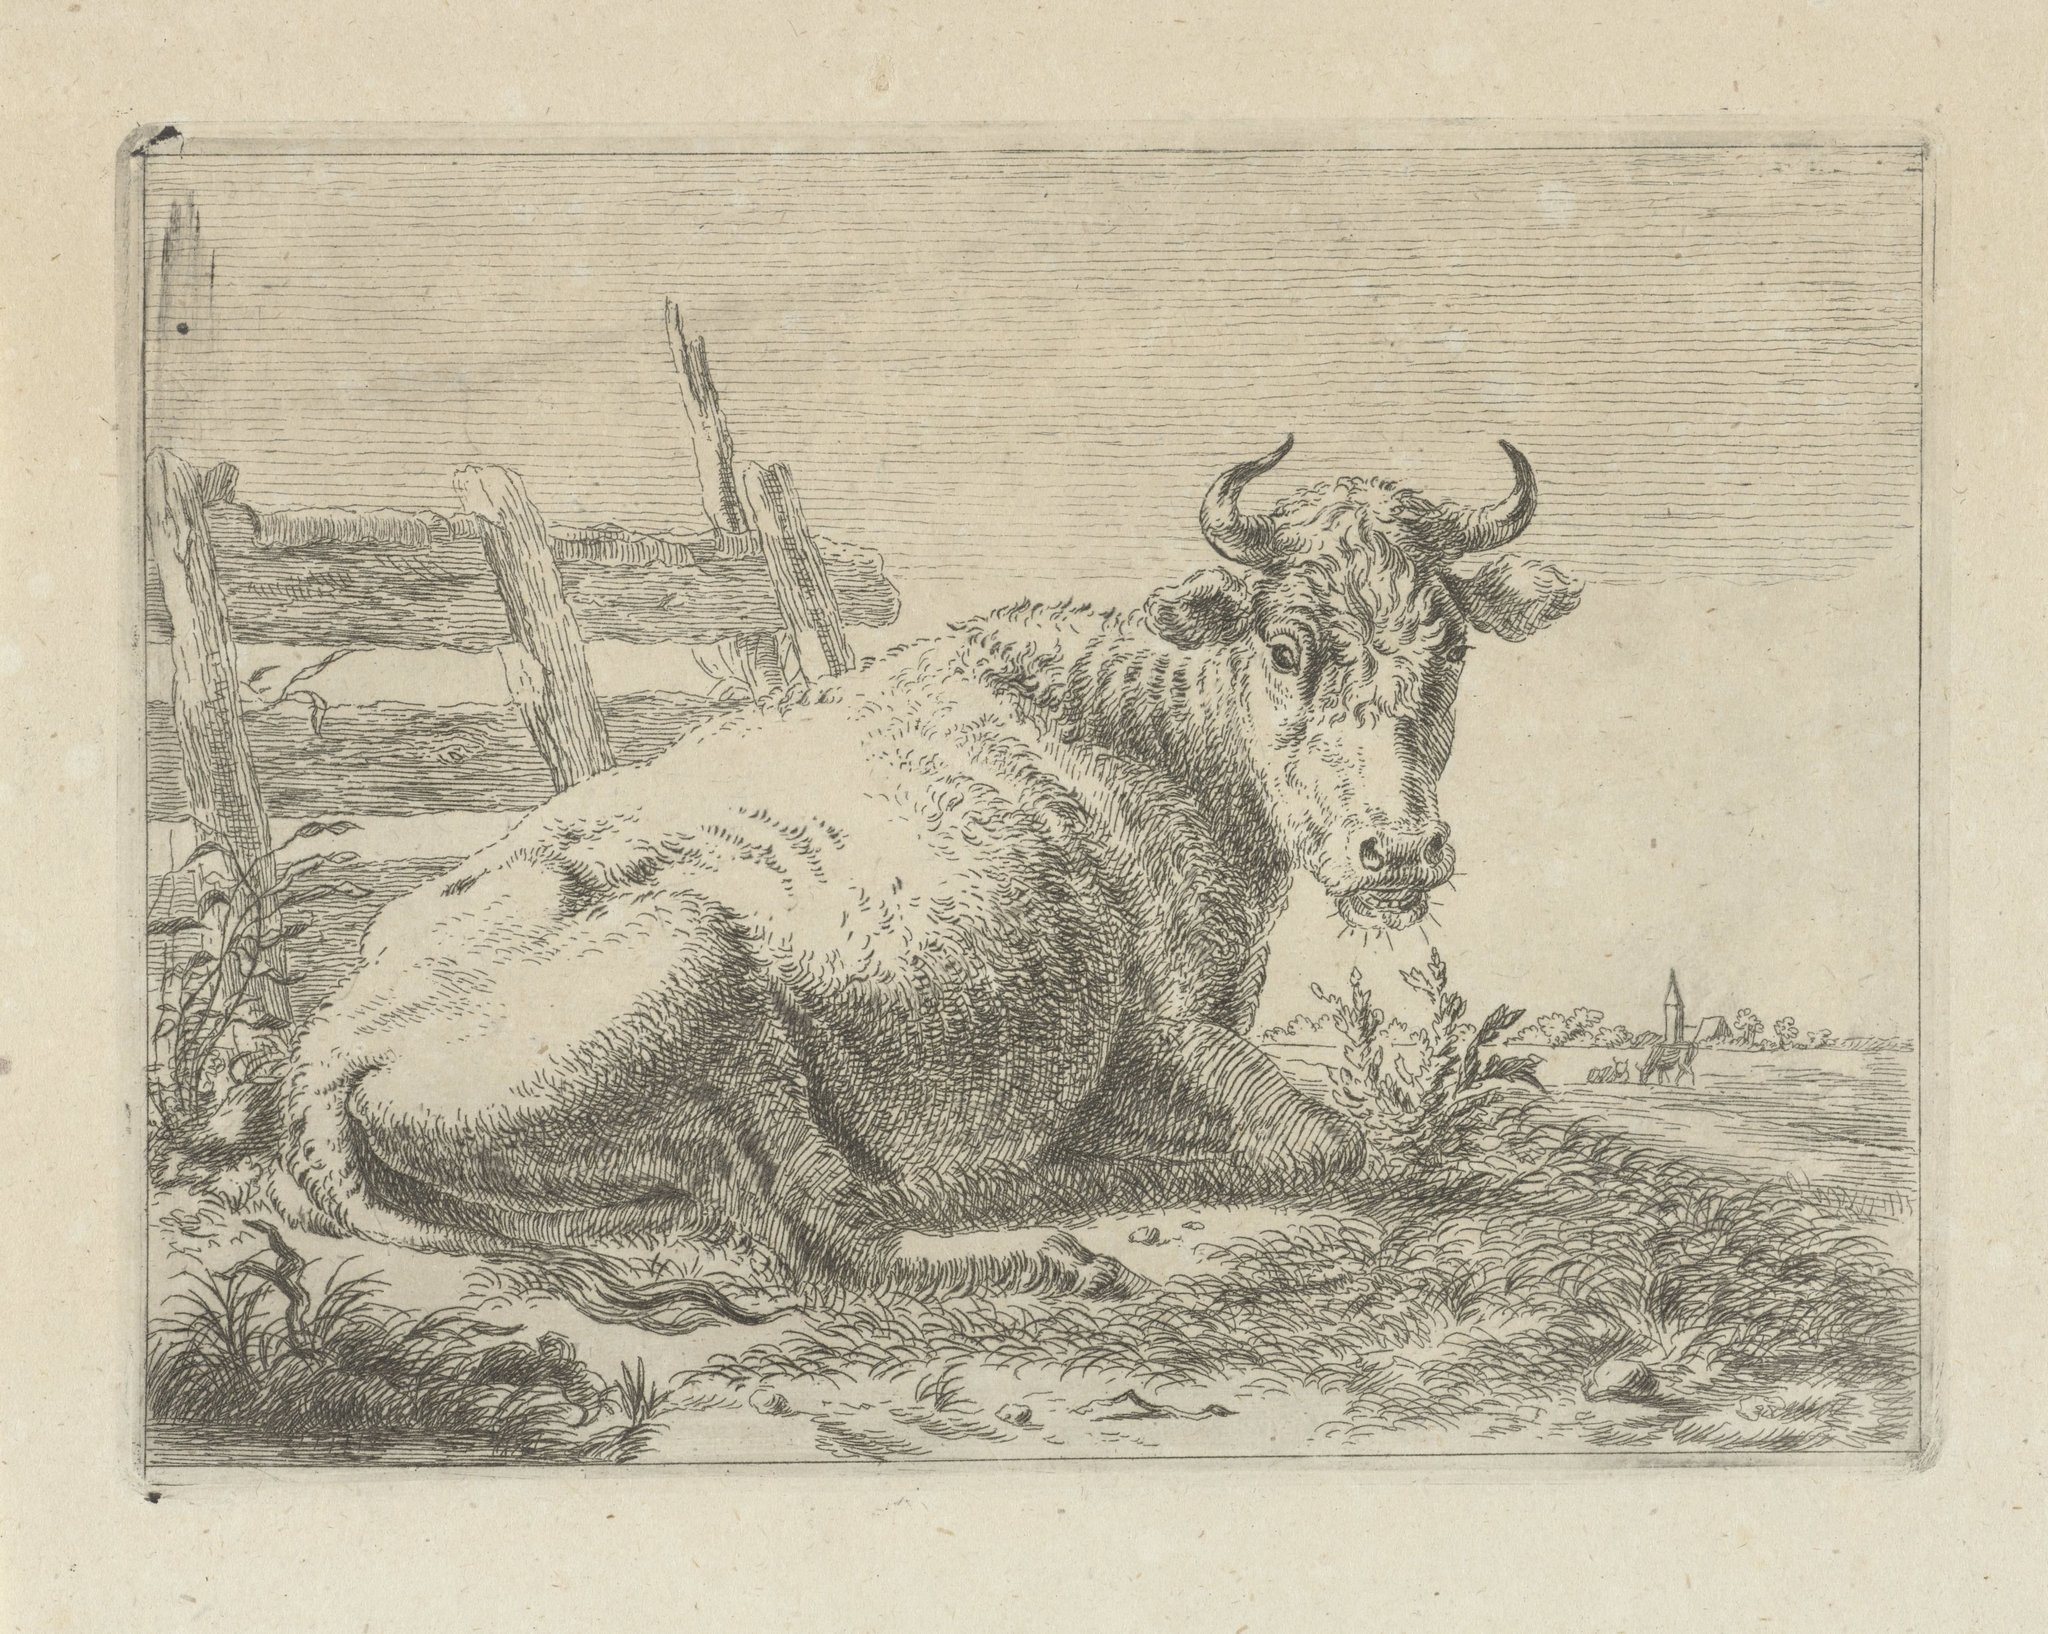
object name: print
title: Liggende koe bij een schutting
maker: Anonymous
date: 1798-1848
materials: paper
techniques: etching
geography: netherlands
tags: cow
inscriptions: collector's mark: Lugt 2228